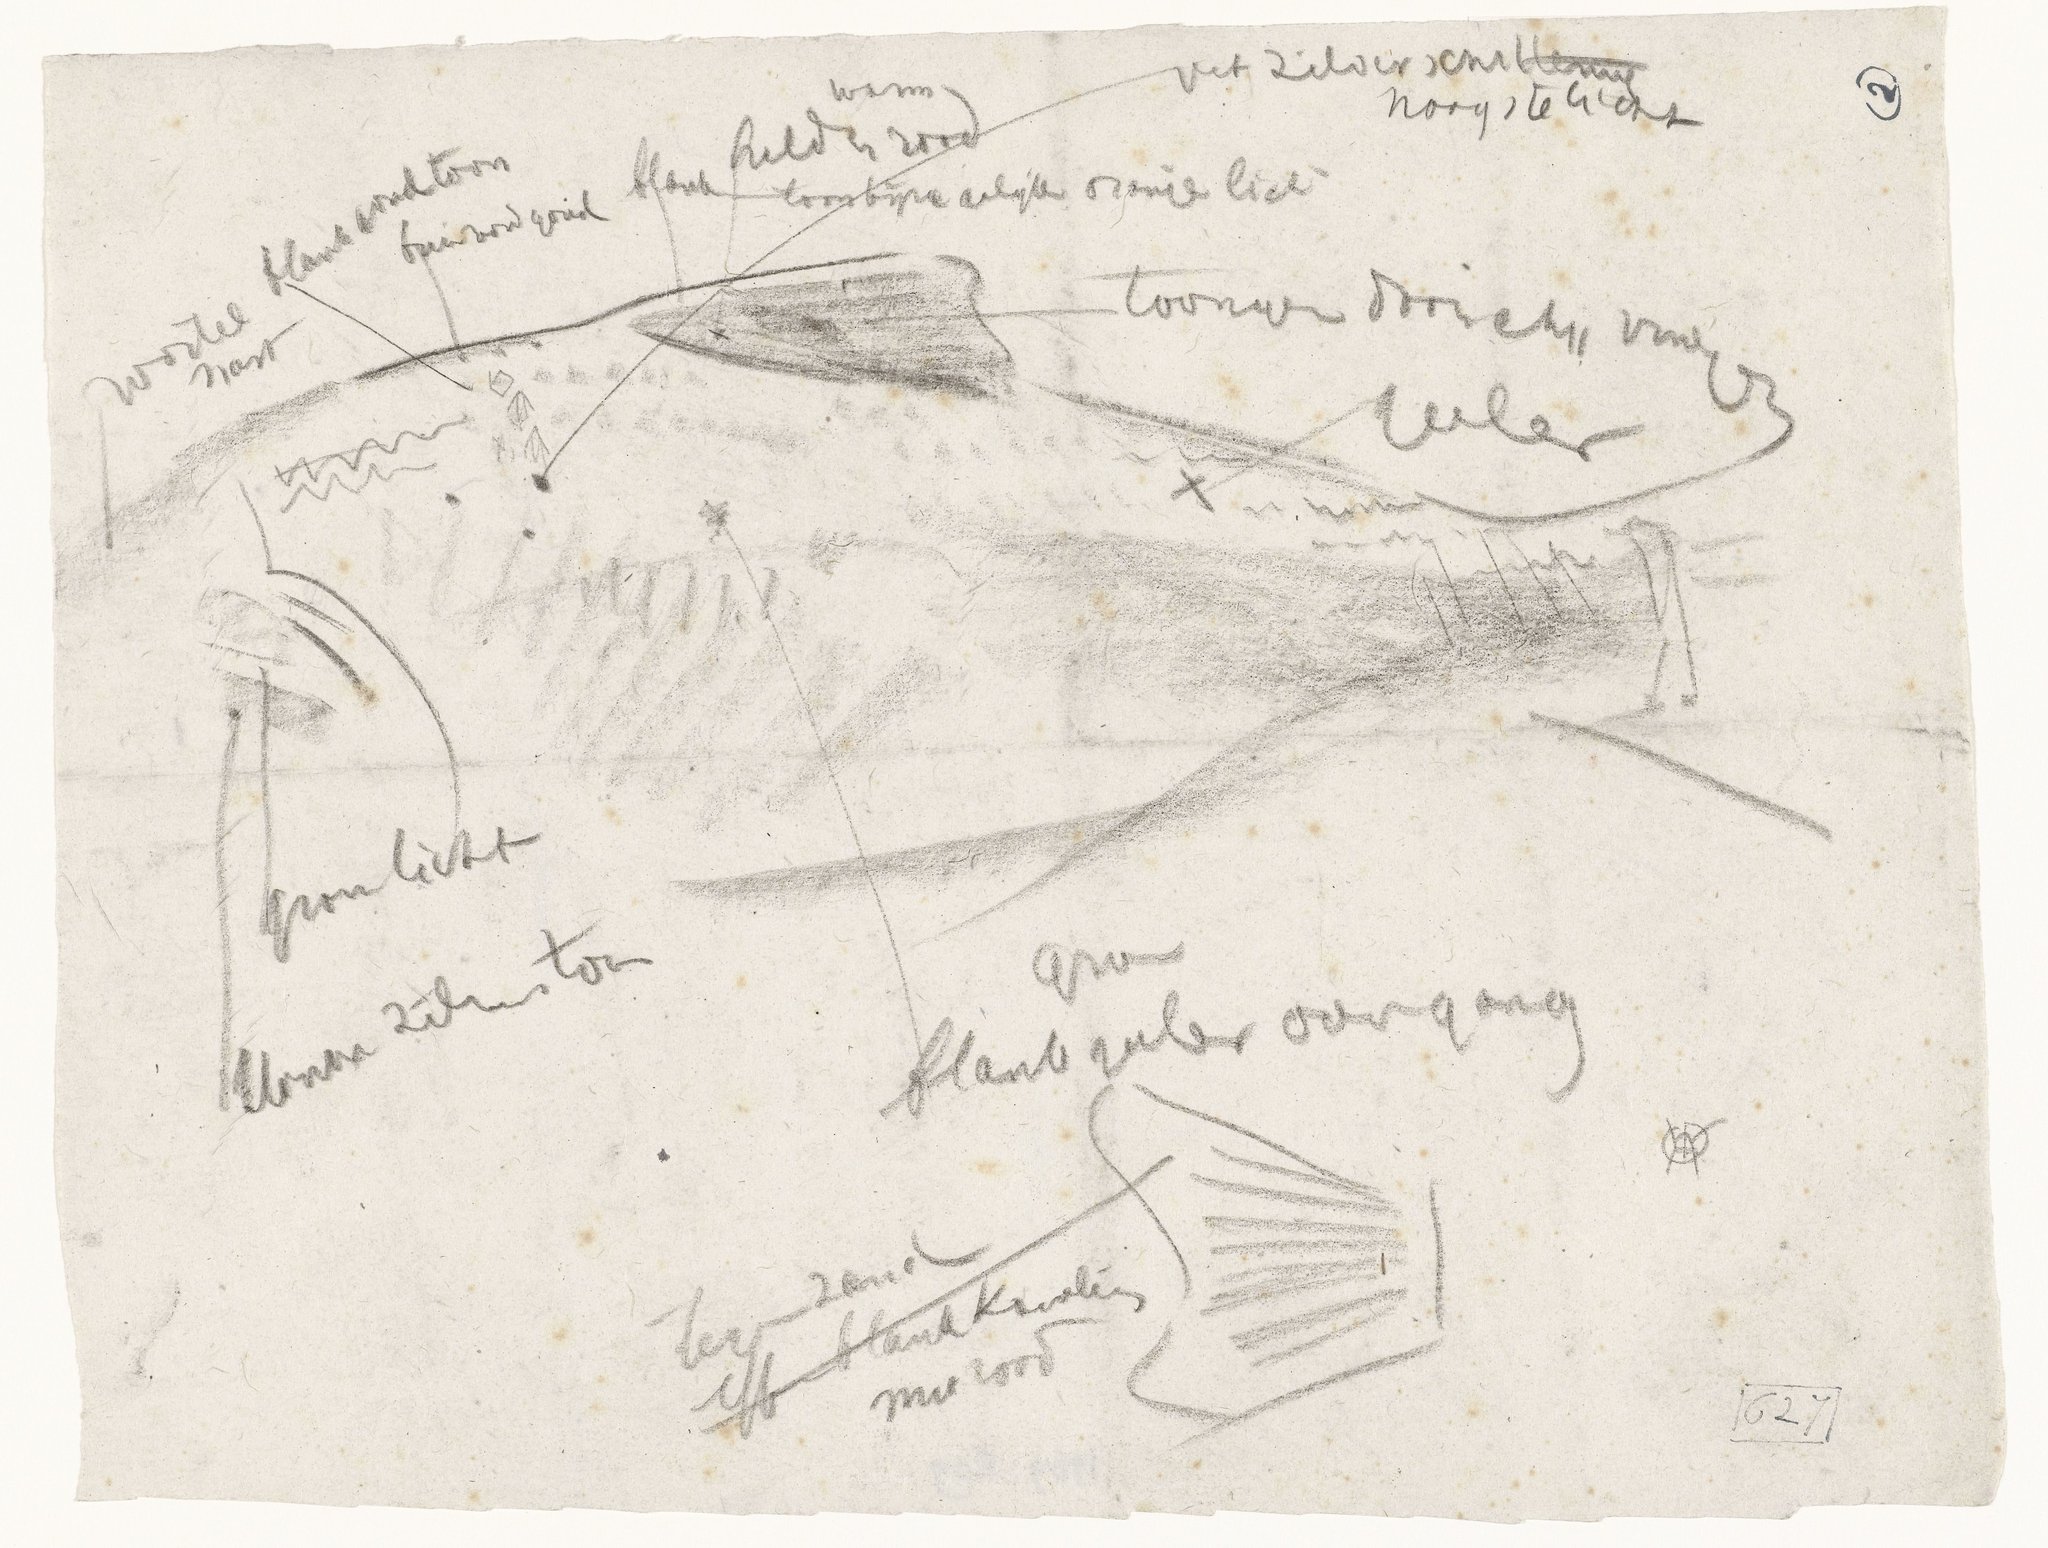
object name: drawing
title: Studies van een vis, met kleurnotities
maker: gerrit willem dijsselhof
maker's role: designer, draughtsman, print maker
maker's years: 1866-1924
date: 1876-1924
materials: chalk, paper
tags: bony fishes